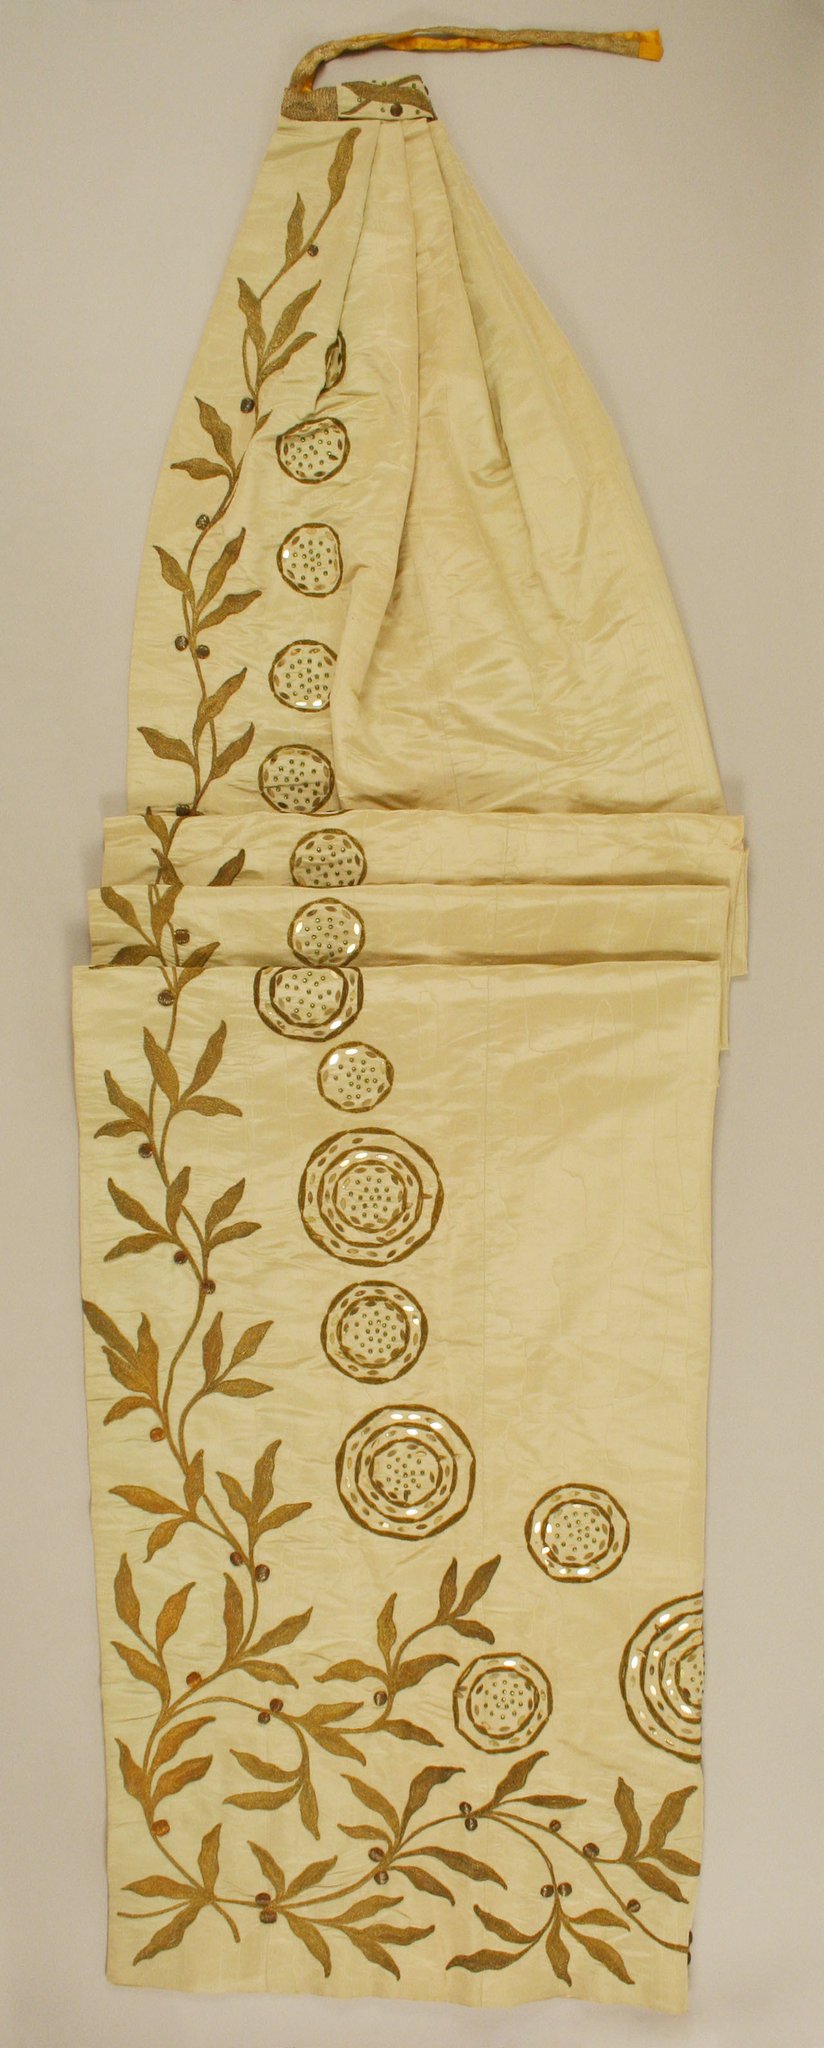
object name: court train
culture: austrian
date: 1893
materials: silk